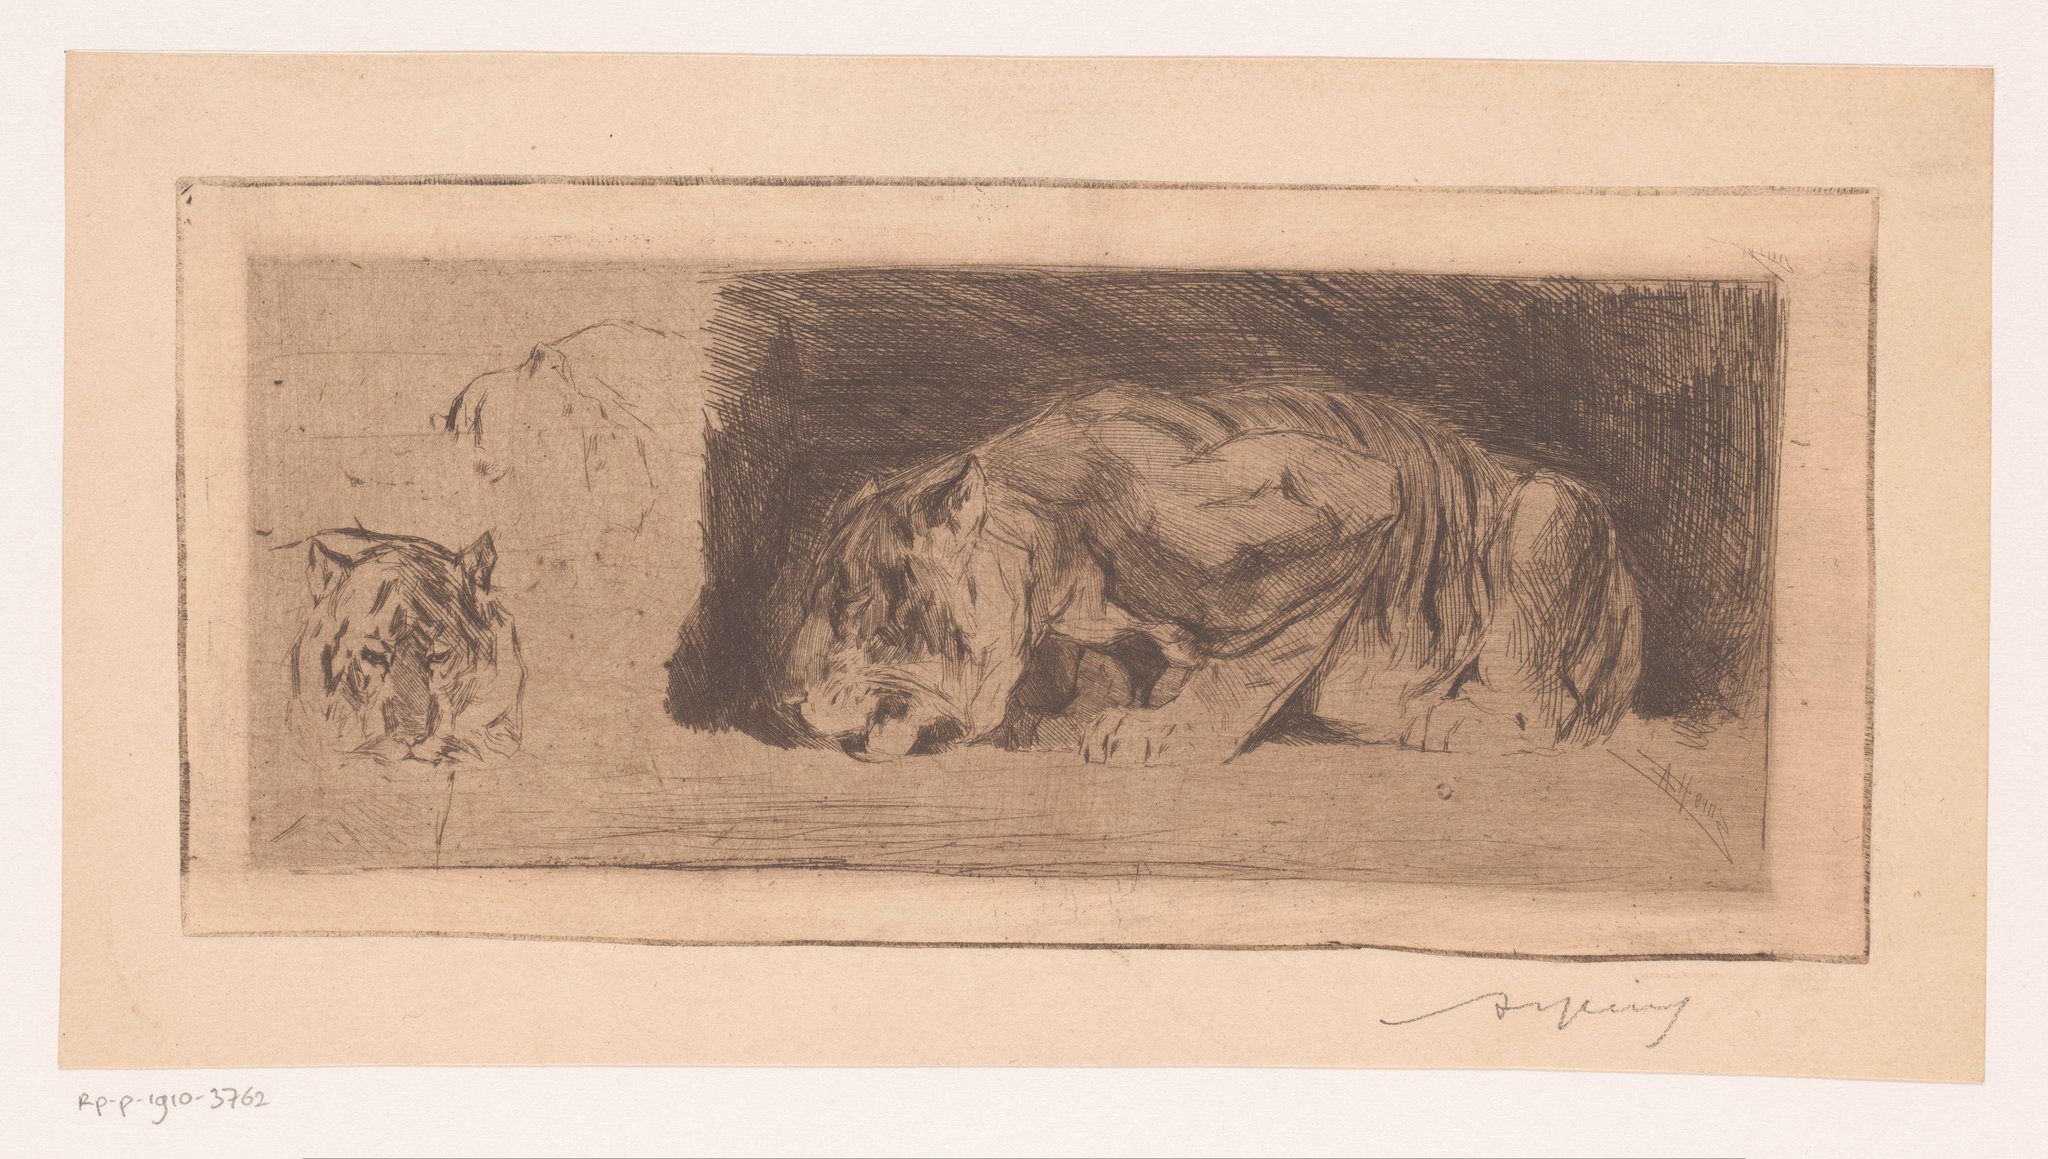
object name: print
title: Studieblad met tijgers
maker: armand heins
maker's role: print maker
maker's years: 1856-1938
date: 1866-1910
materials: paper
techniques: etching, intaglio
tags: beasts of prey, predatory animals: tiger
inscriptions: collector's mark: Lugt 2228